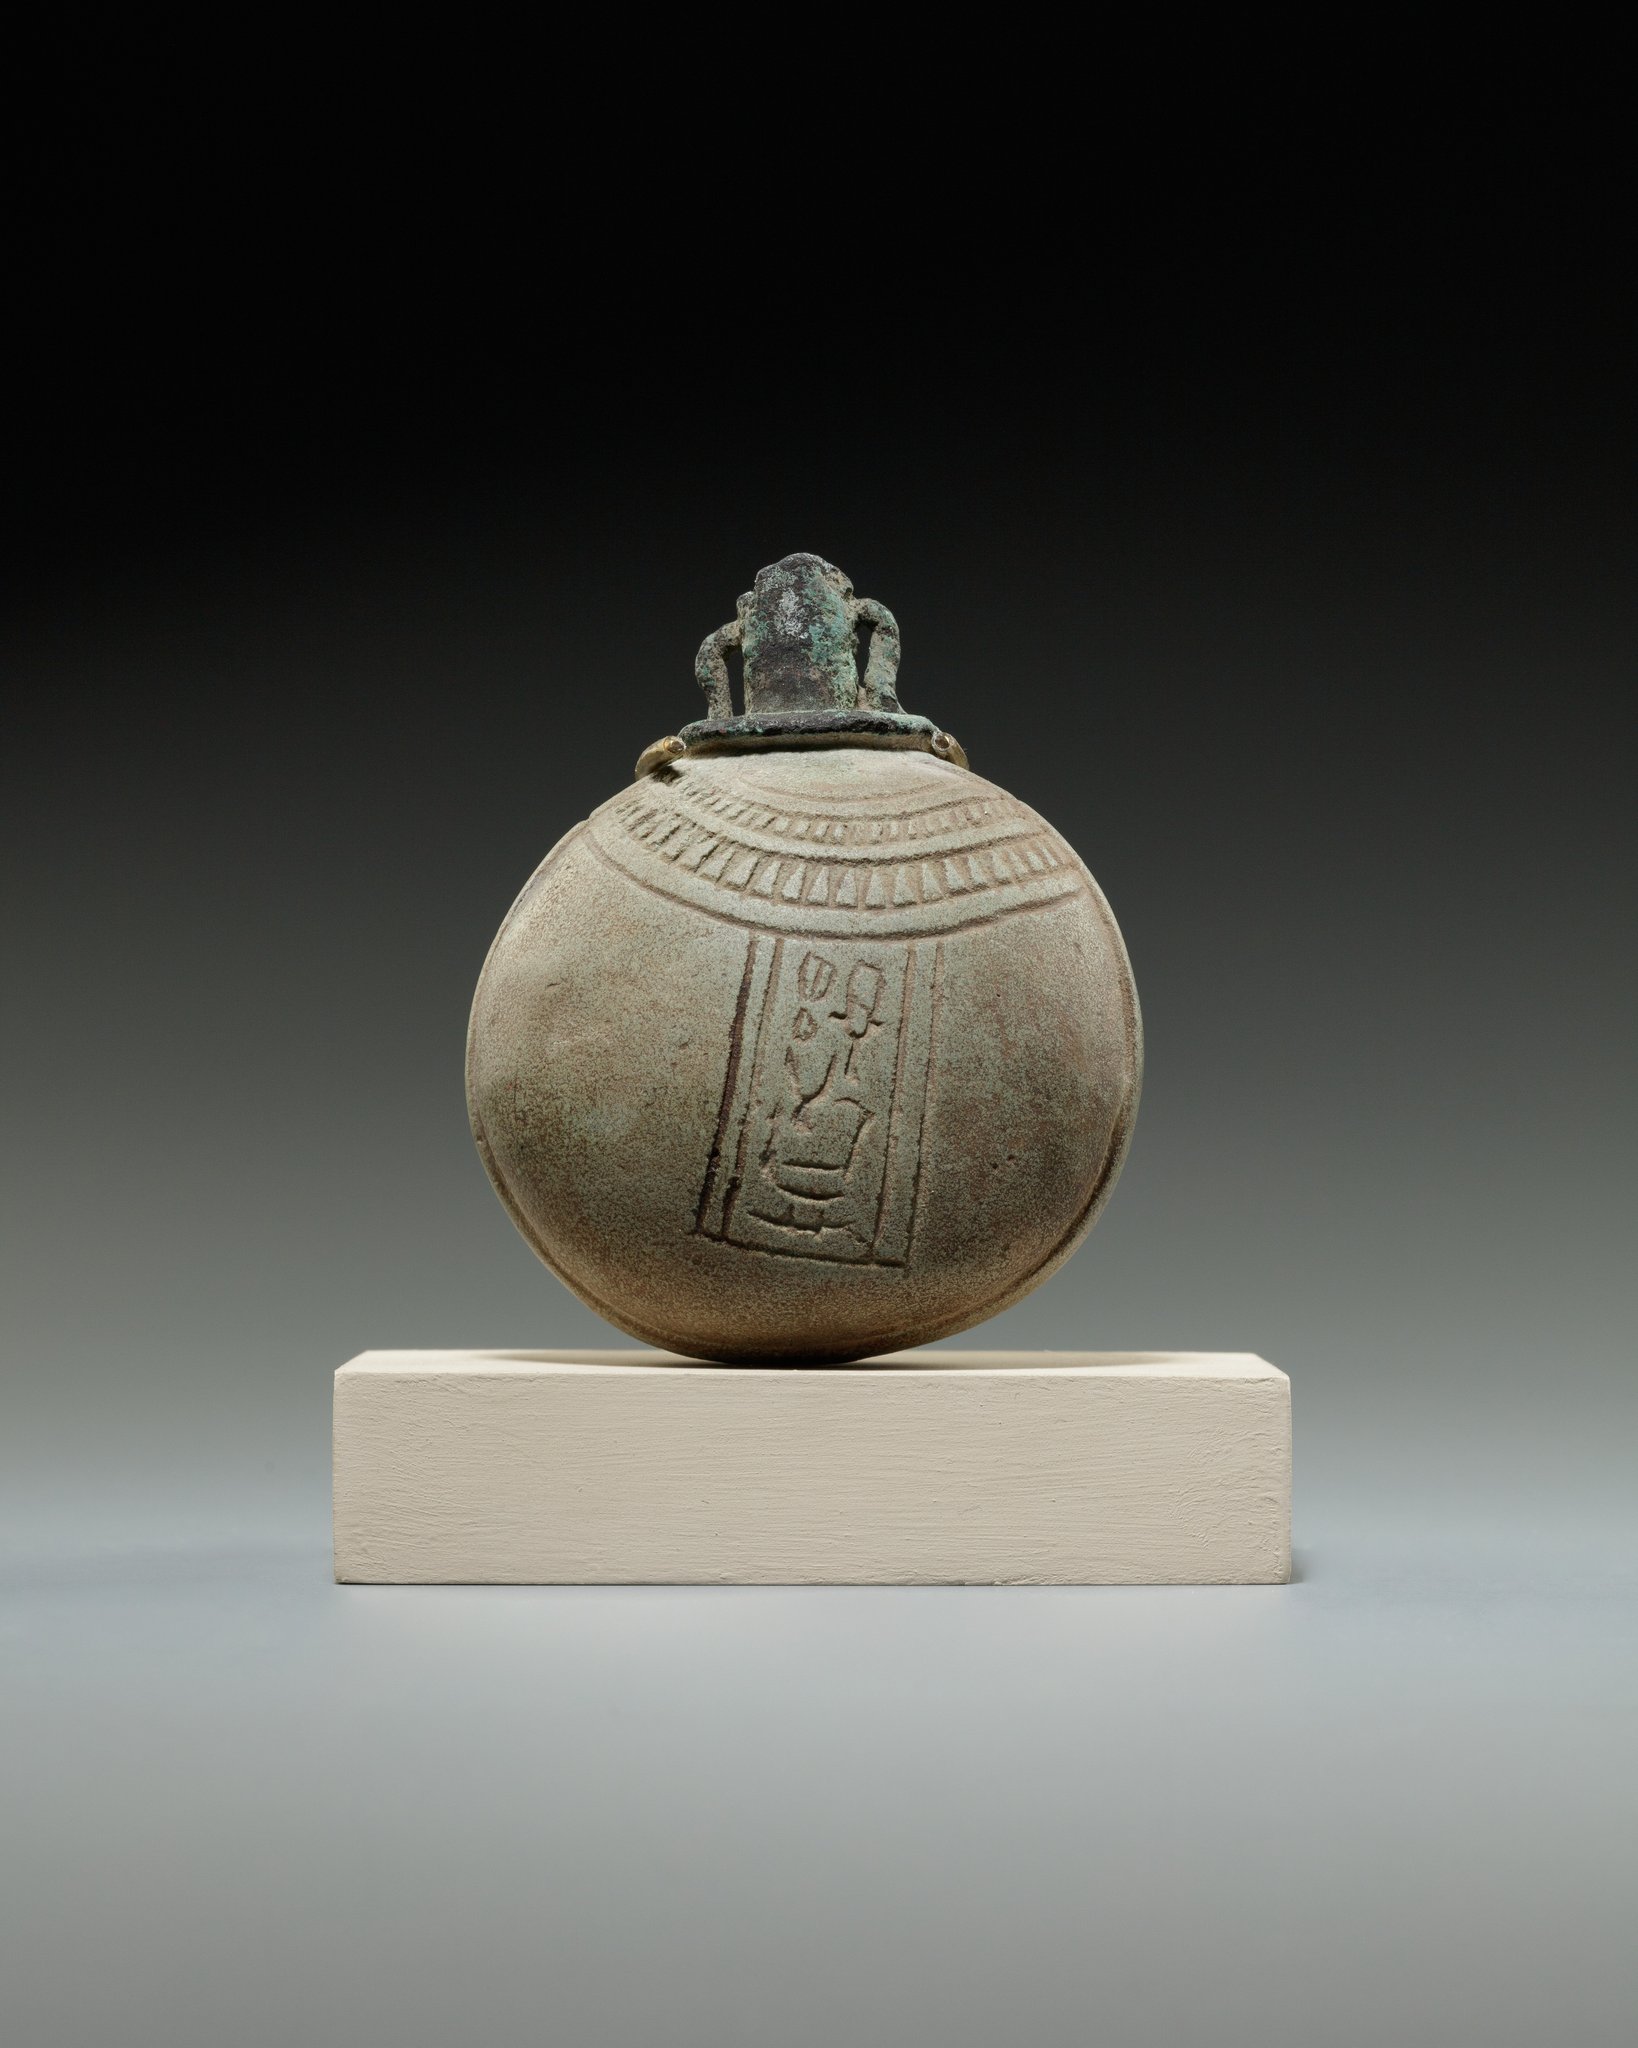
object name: bottle, new year's bottle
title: Lentoid Bottle ("New Year's Bottle")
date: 664-332 BCE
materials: faience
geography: egypt